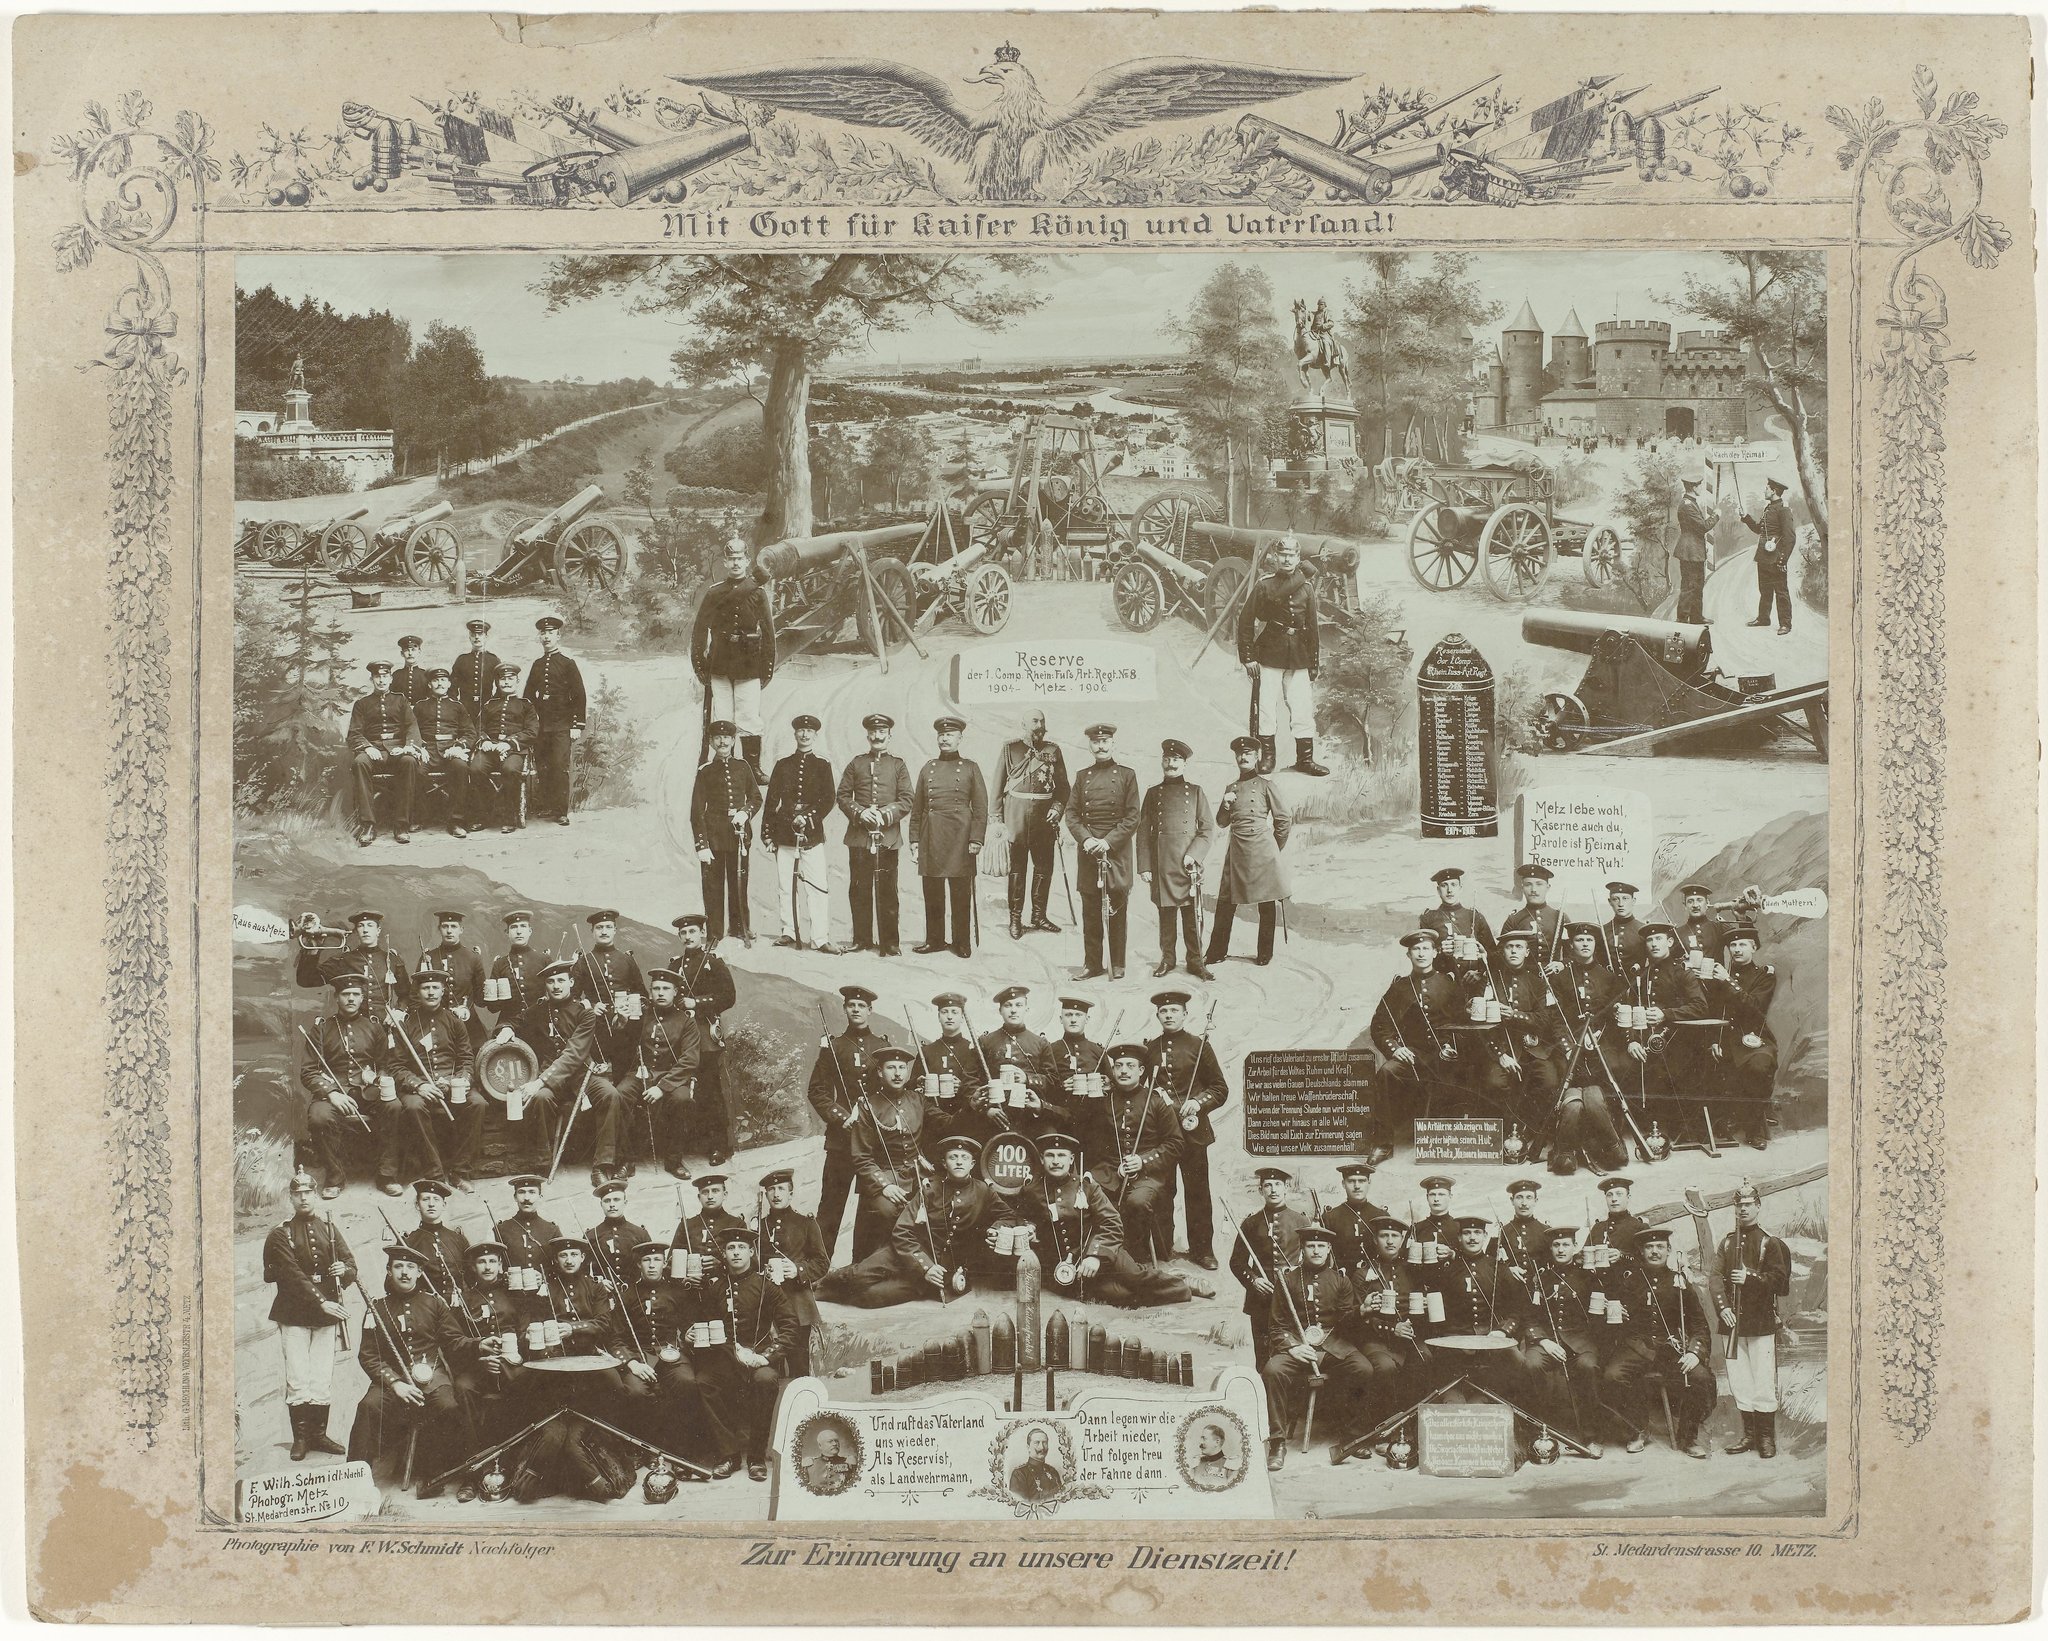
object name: photocollage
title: Group Portrait of Reservists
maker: f.w. schmidt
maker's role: fotograaf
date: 1904-1906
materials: paper, cardboard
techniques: collodion silver print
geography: metz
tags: the company, the unit, the troop ~ military service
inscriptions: inscription: ‘Mit Gott für Kaiser Köig und Vaterland!/ Zur Erinnerung an unsere Dienstzeit/ Photographie von F.W. Schmidt Nachfolger/ St. Medardenstrasse 10. METZ.’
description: ‘In memory of our time in military service’: there were photographers in German barrack cities who specialised in taking individual or group portraits of soldiers. Many such photographs were produced around 1900. Schmidt assembled numerous small photographs into a new, large entity. Typical of such collages is the combination of patriotism, camaraderie, sense of duty, and jollity.